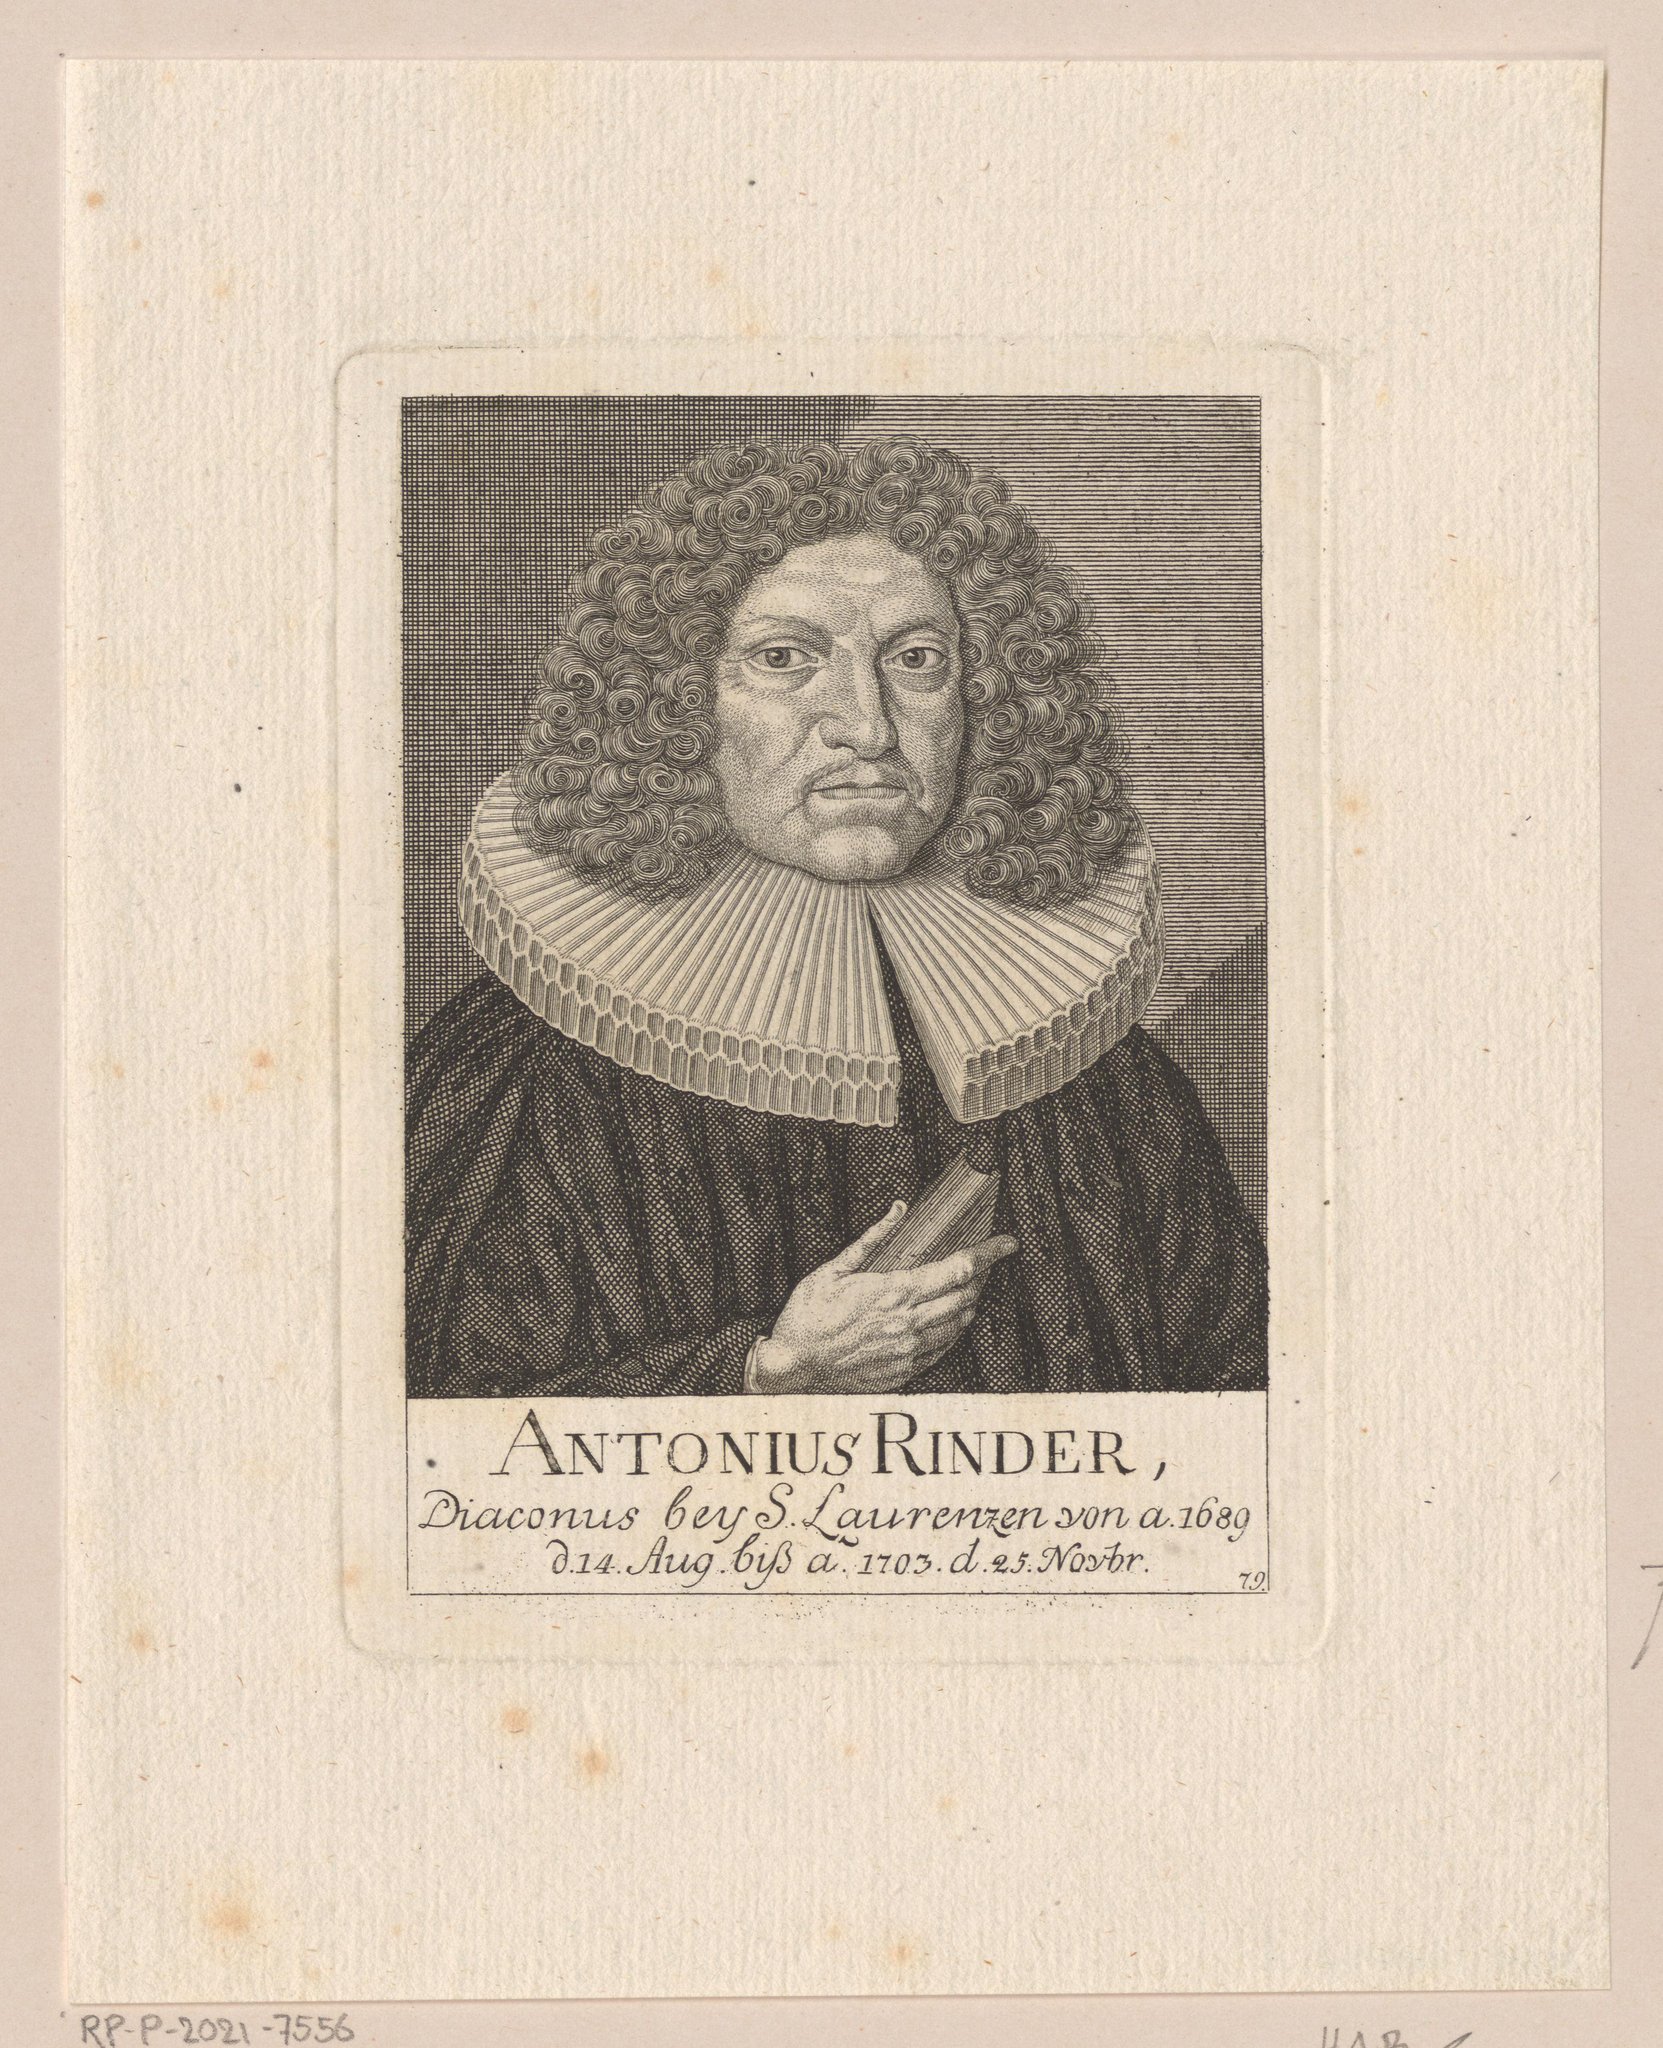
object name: print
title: Portret van Anton Rinder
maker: Anonymous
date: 1756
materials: paper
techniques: engraving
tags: historical persons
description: Prent mogelijk uit: Würfel, Andreas. Diptycha ecclesiae Sebaldianae (...). Neurenberg: Christoph Melchior Roth, 1756.